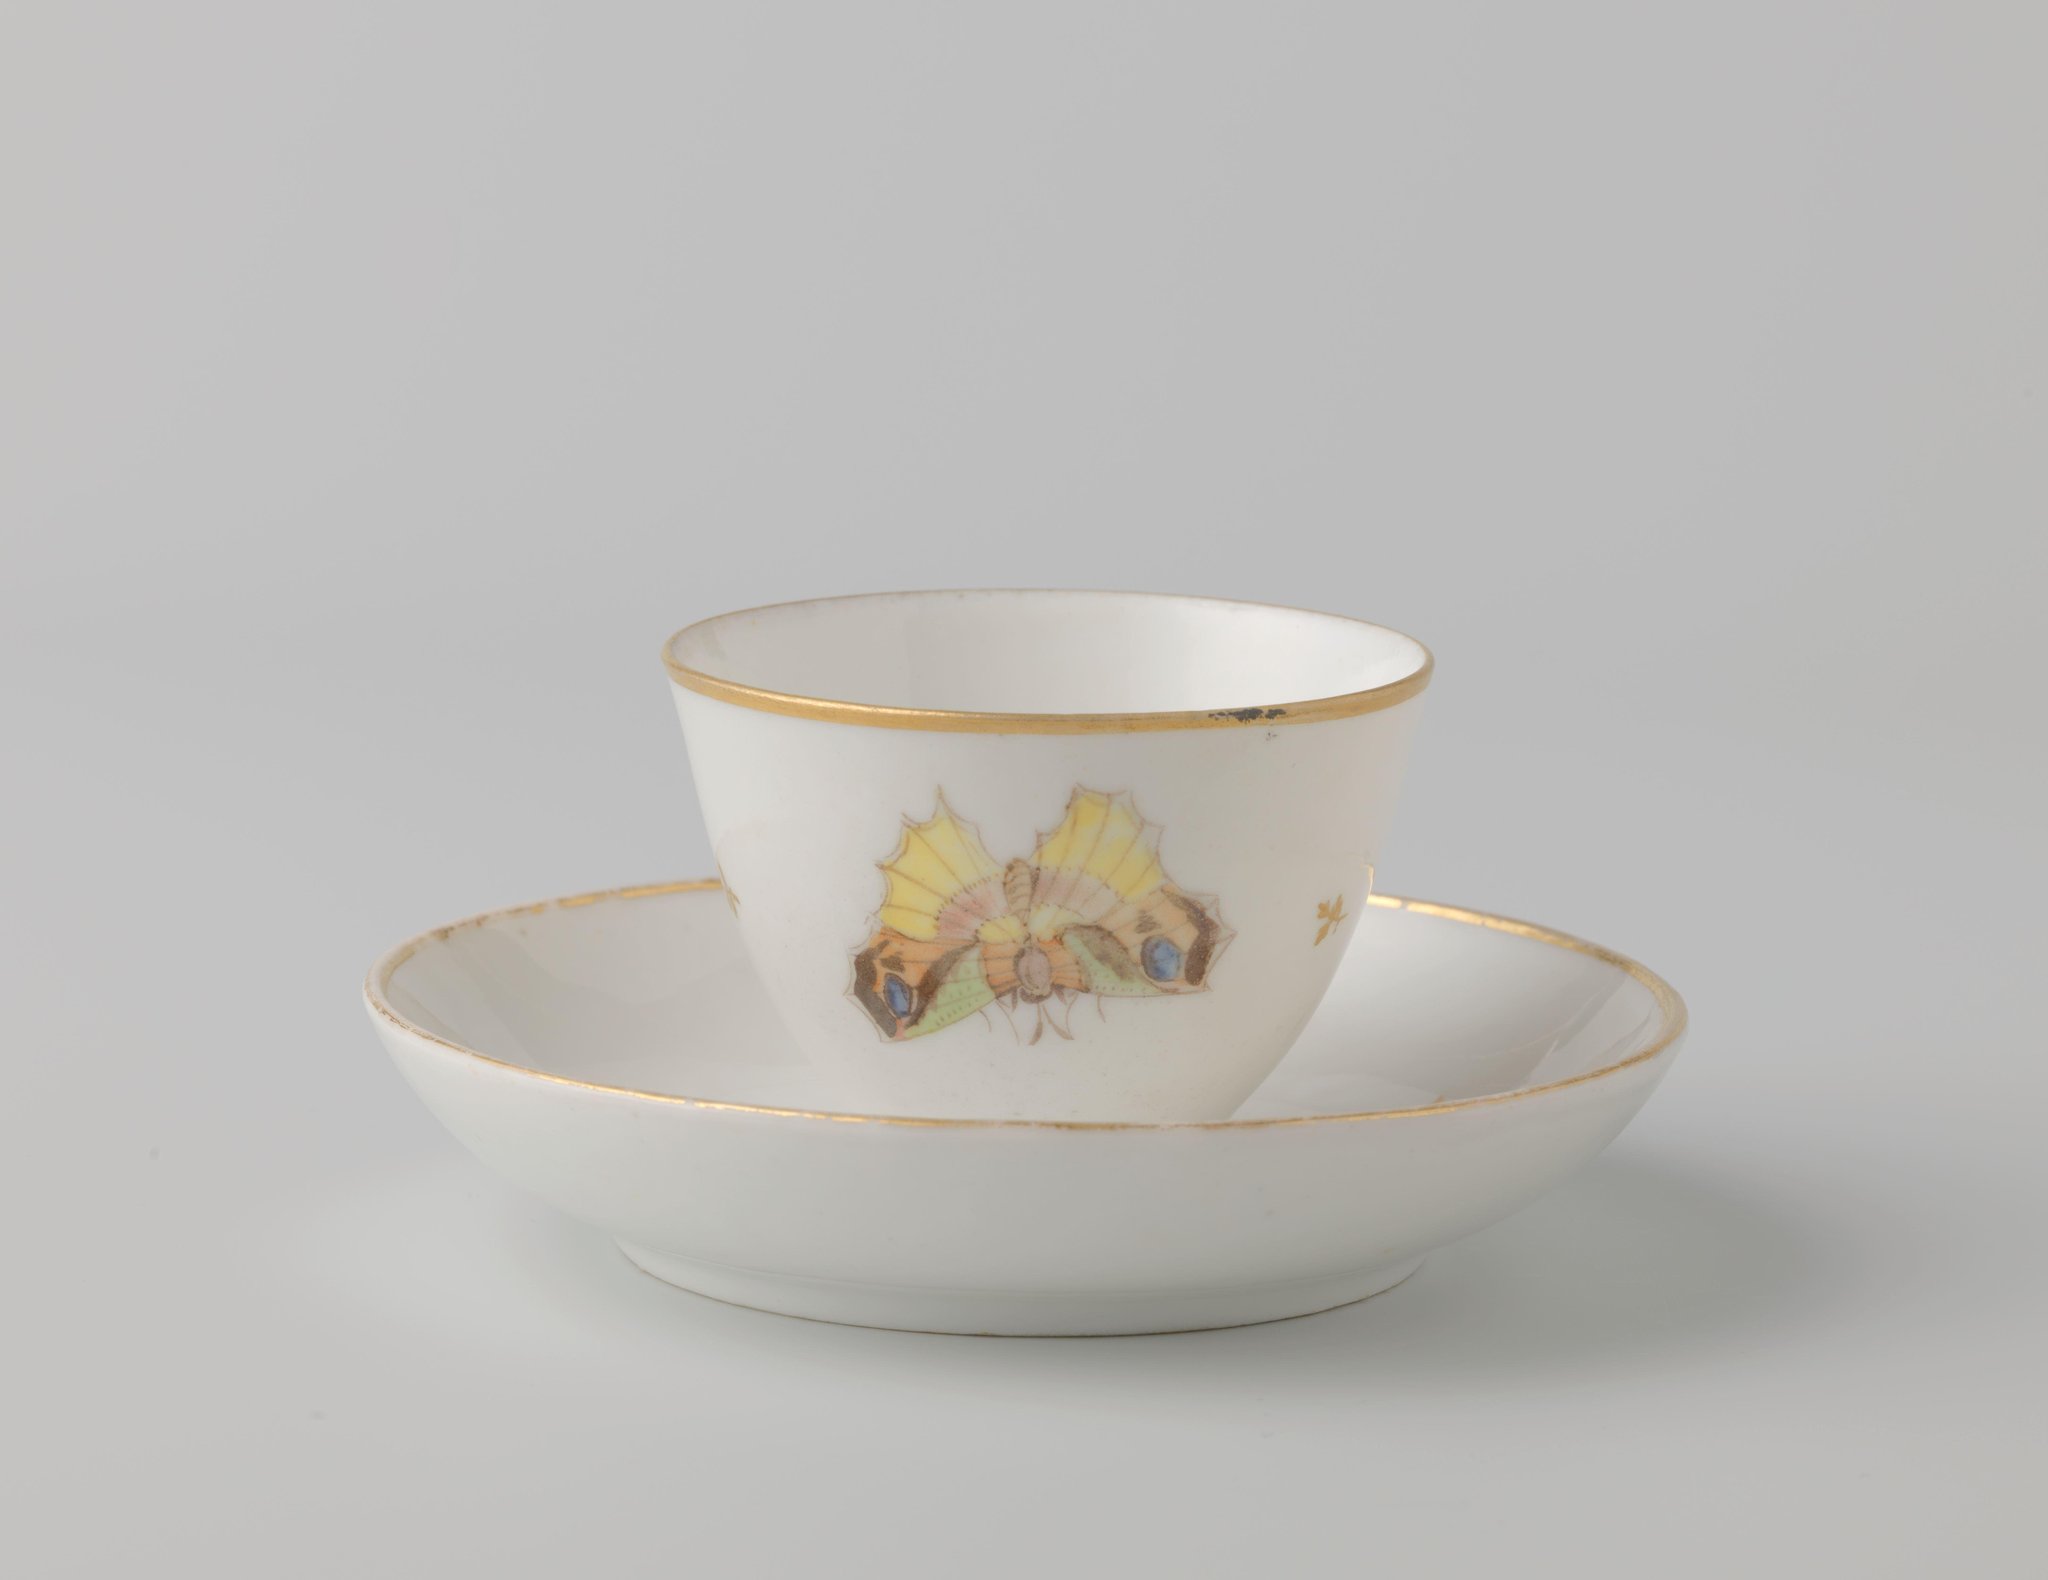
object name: platter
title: Schotel beschilderd met vlinders en libellen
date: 1784-1809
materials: porcelain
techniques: painted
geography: ouder-amstel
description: Schotel, veelkleurig beschilderd met vlinders en libellen. Gemerkt: Amstel.